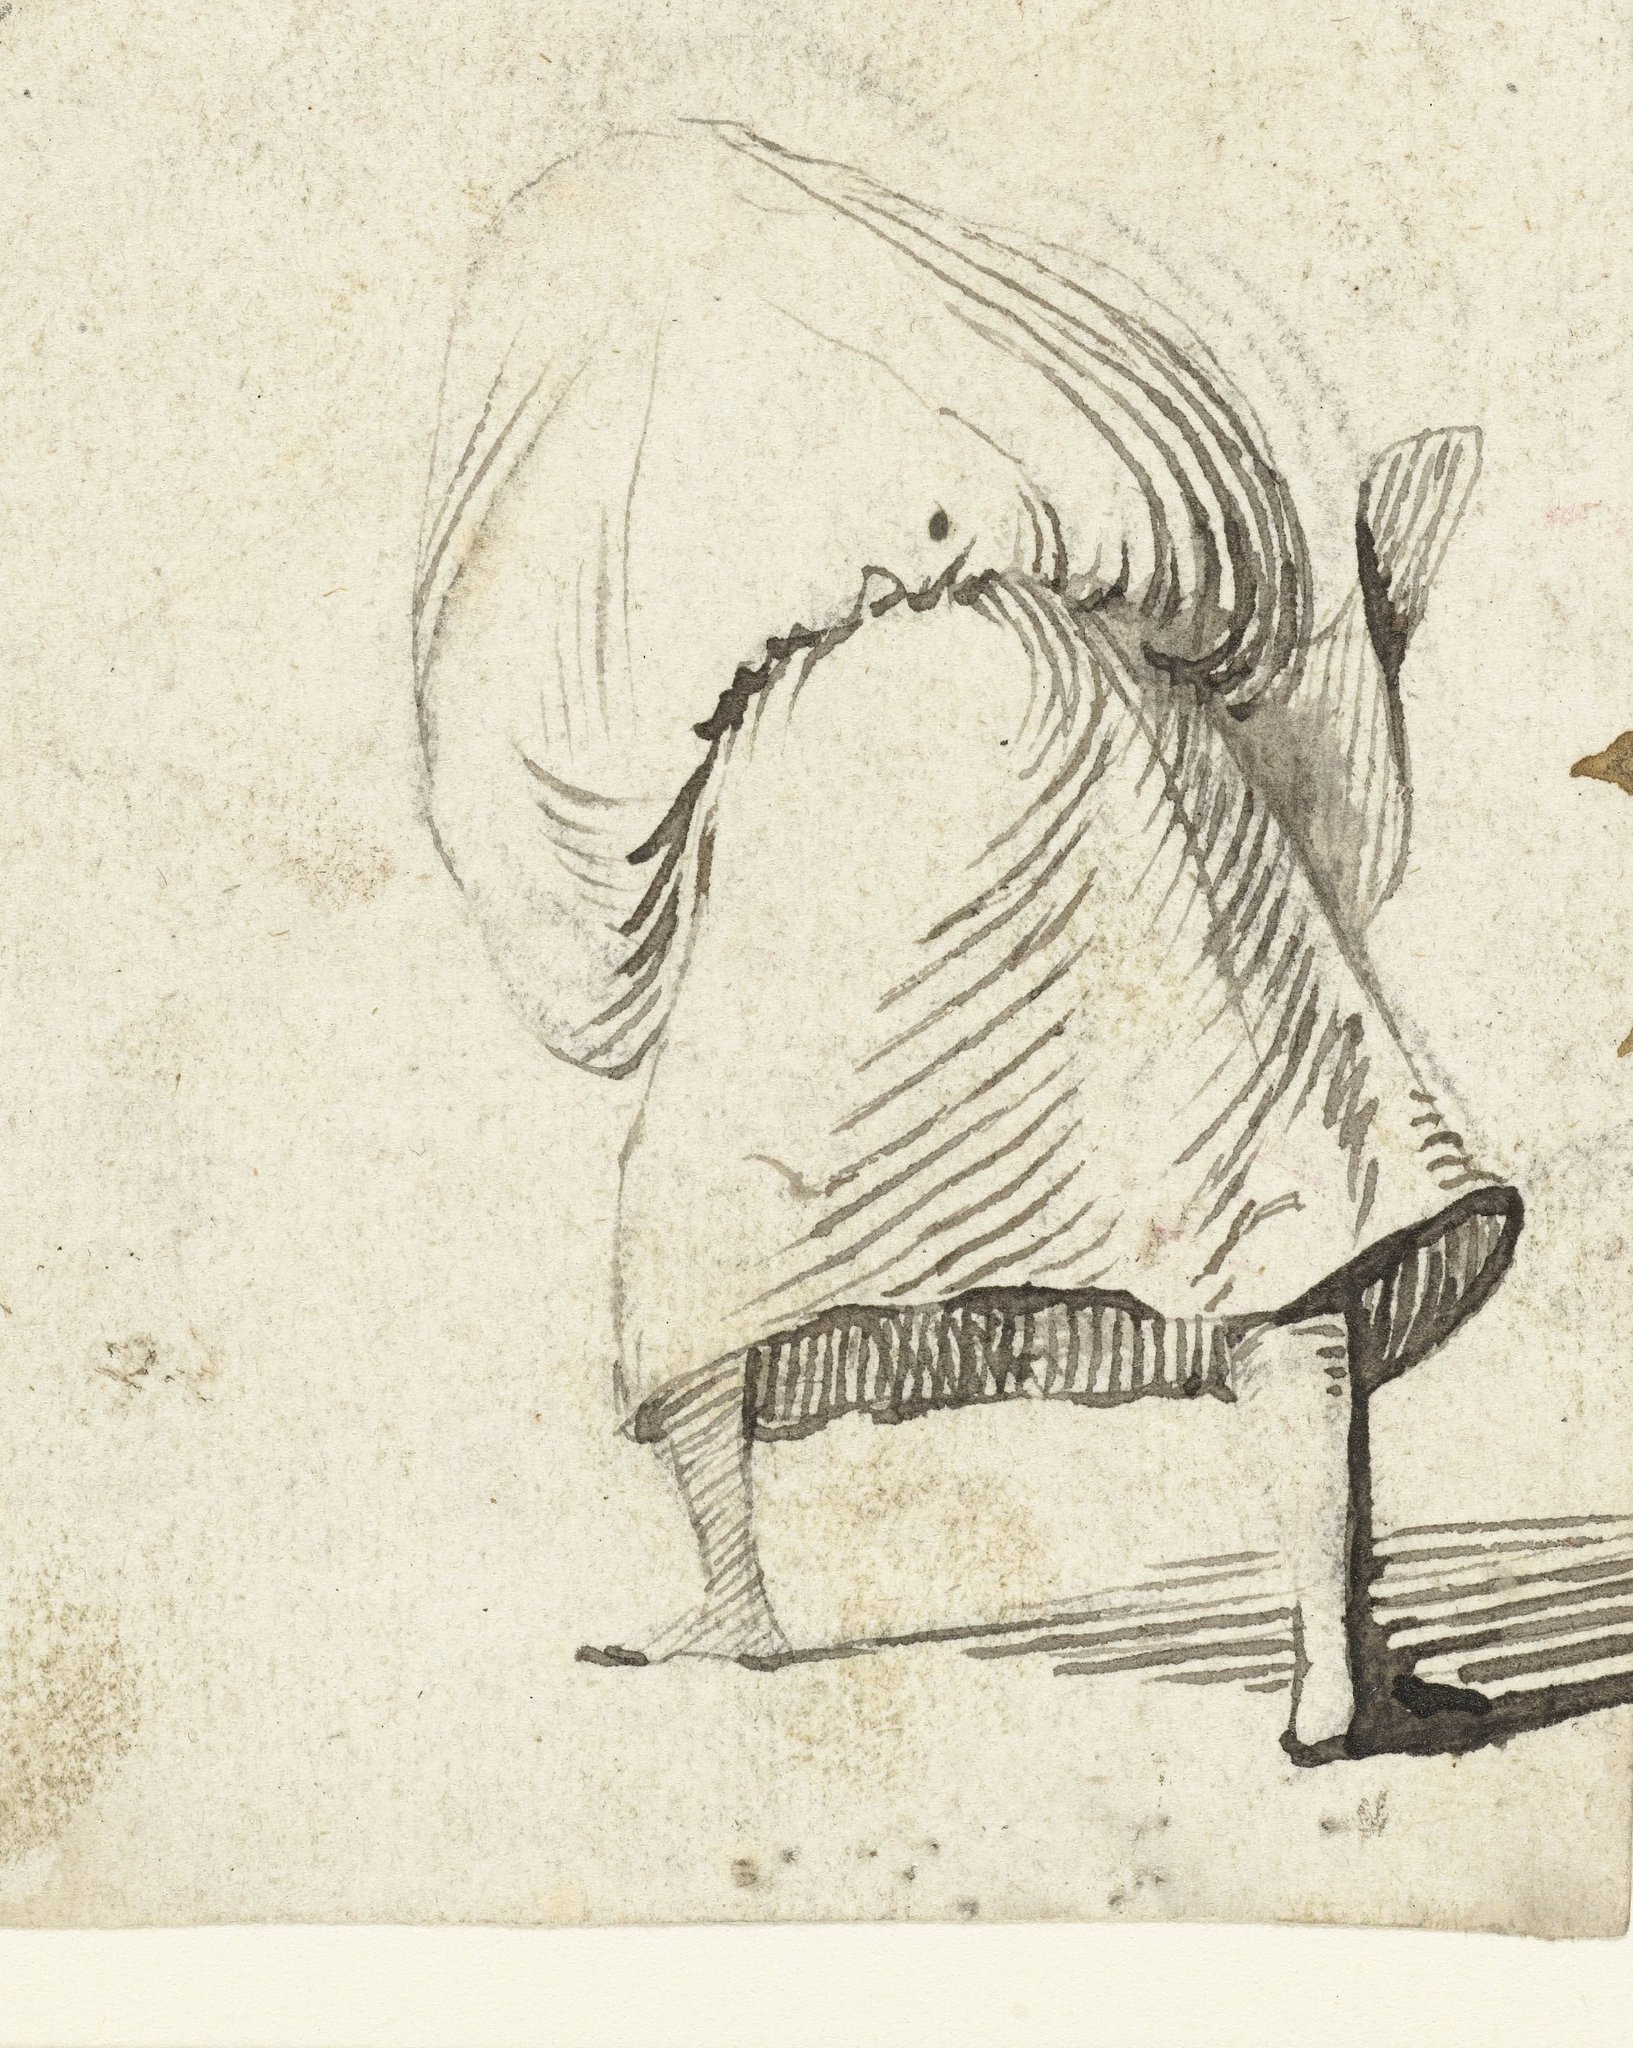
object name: drawing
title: Vrouw met rok over haar hoofd, van achteren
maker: harmen ter borch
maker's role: draughtsman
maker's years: 1638-1677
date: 1651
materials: chalk, ink, paper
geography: zwolle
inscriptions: annotation: ‘Har[man] t.Borch.inventor de[n].4.Novem[br] 1651’